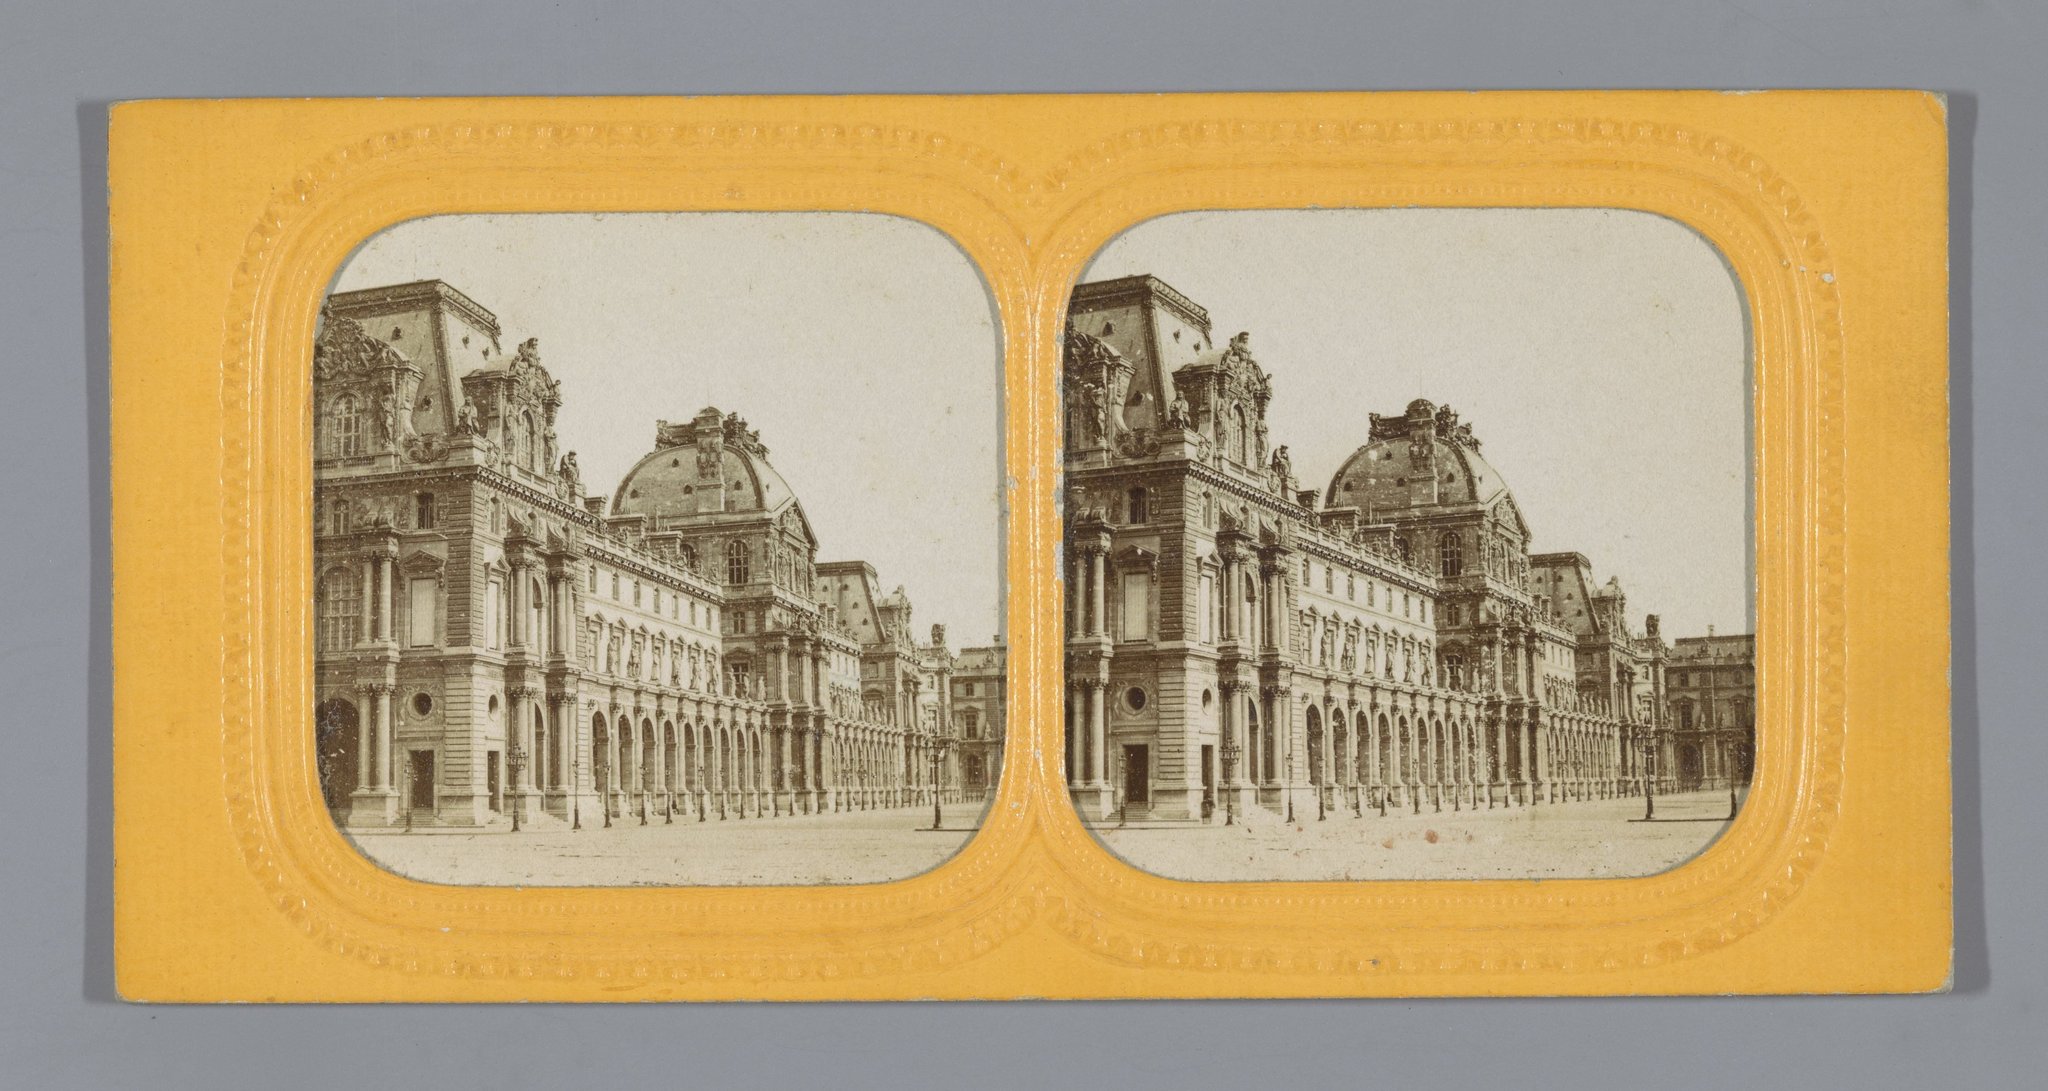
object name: tissue stereograph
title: Le Louvre, Paris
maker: Anonymous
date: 1855-1875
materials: cardboard, paper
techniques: albumen print, hand coloring, perforating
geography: paris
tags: palace